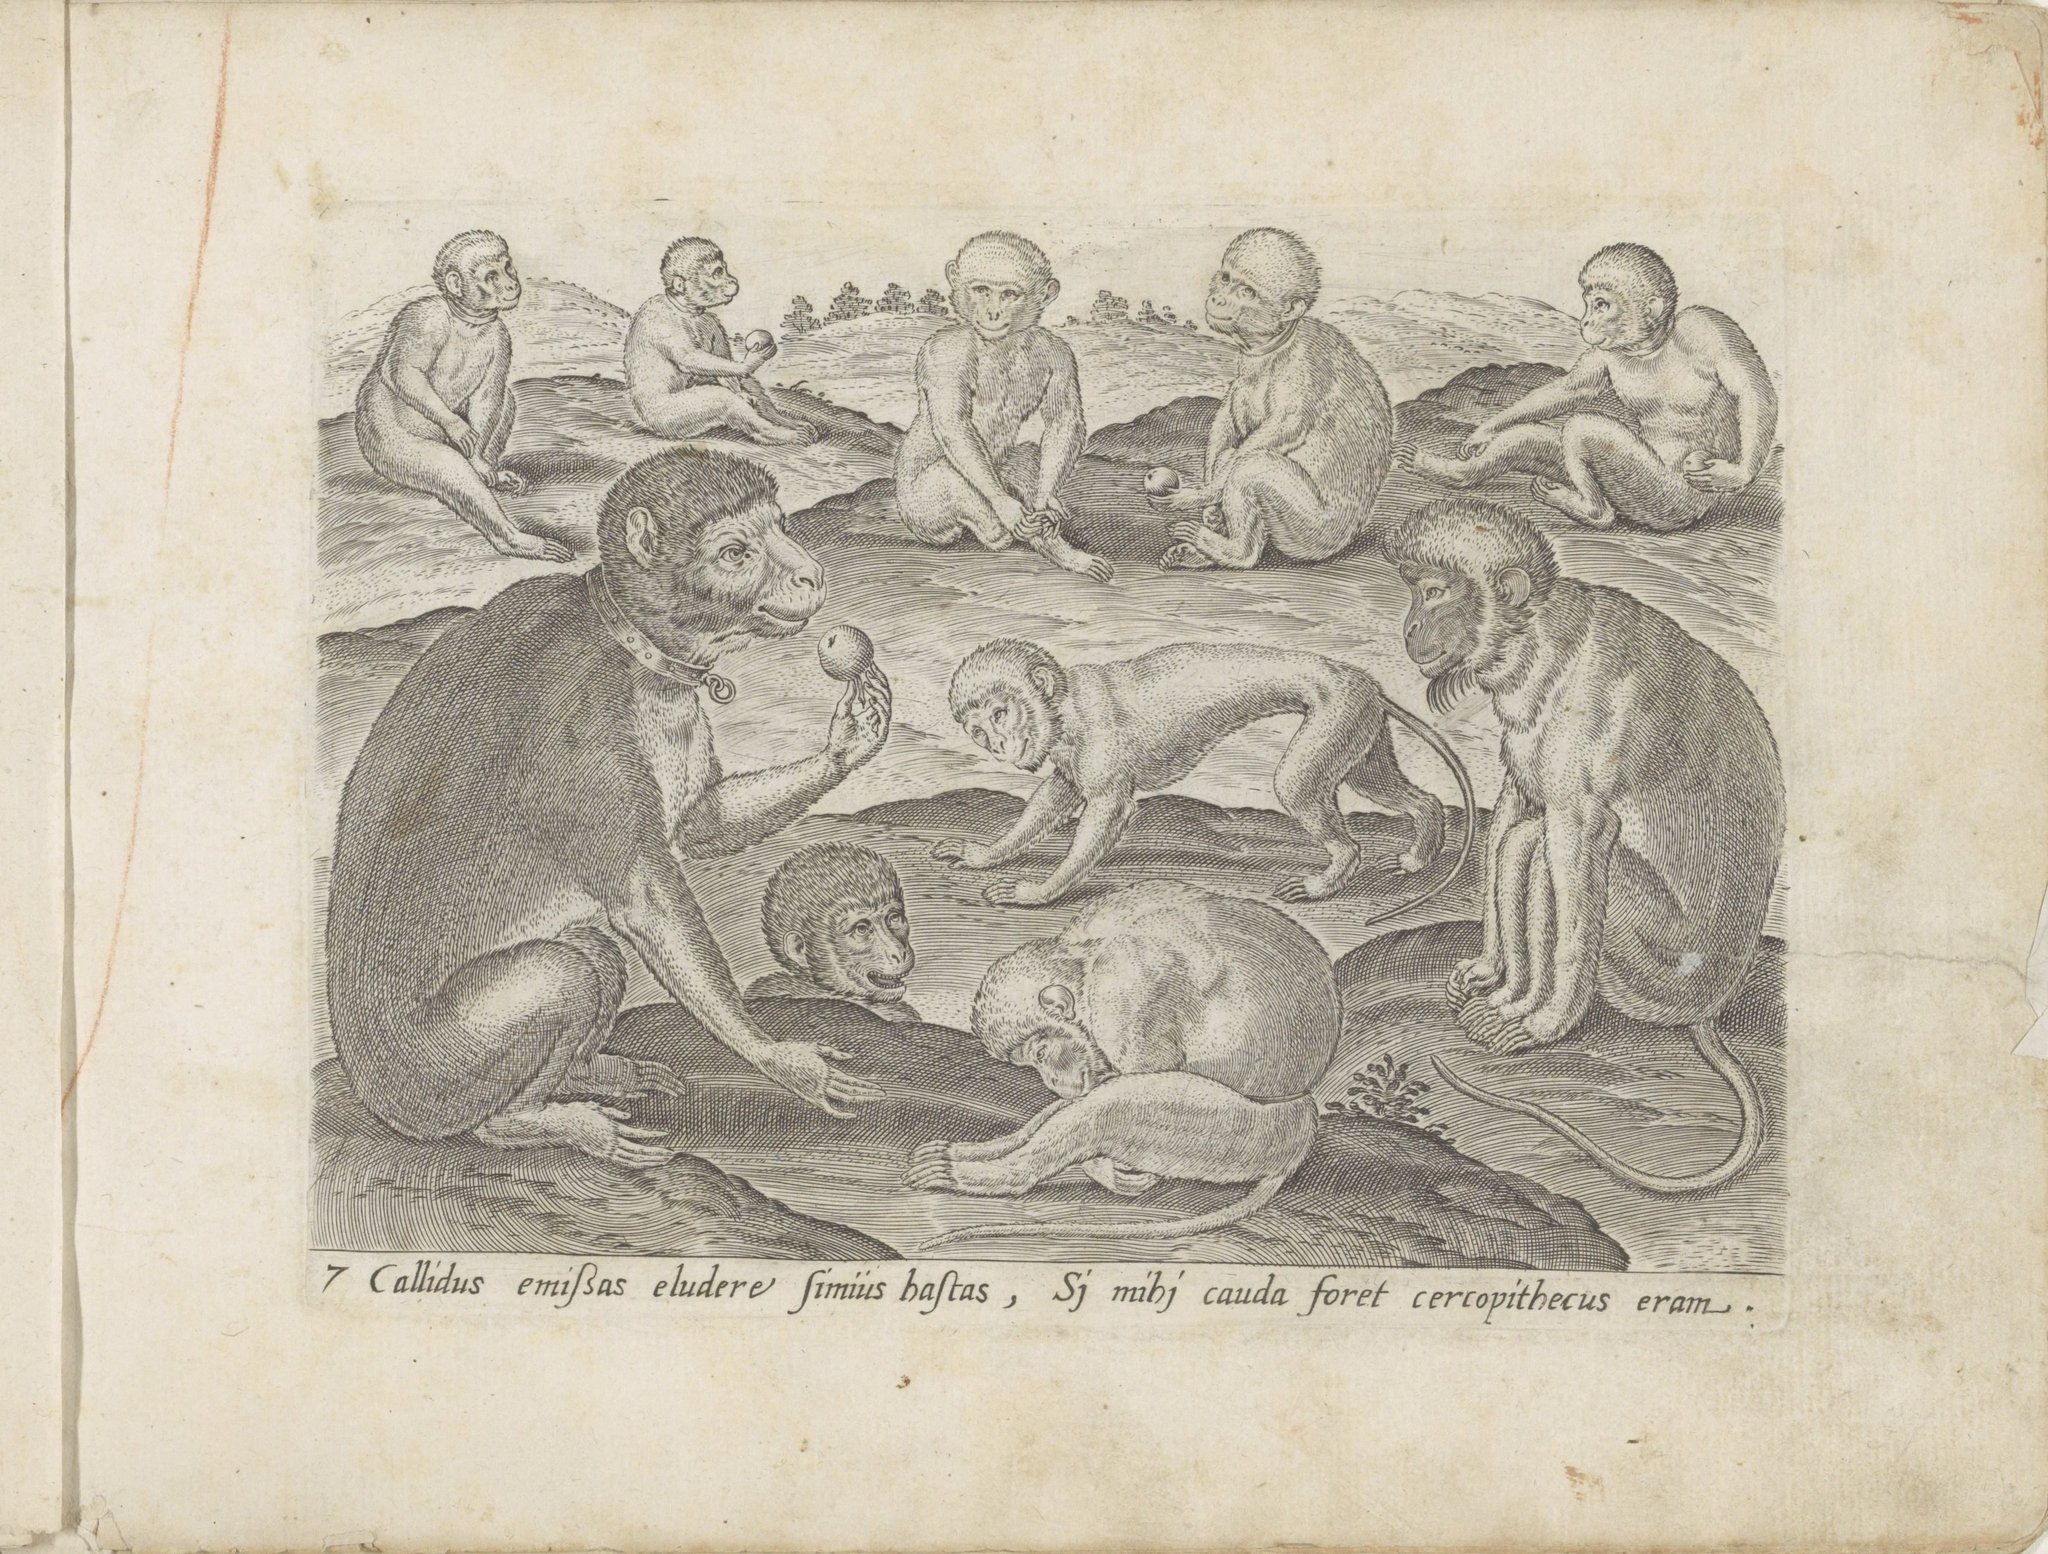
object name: album leaf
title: Verschillende apen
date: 1581-1600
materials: paper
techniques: engraving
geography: netherlands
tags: monkeys, apes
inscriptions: inscription: ‘7: Callidus emissas eludere simius hastas, Si mihi cauda foret cercopithecus eram.’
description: Apen. Op de voorgrond een grote zittende aap, naar rechts, een appel etend. Voor hem een zich krabbende aap en, rechts een aap met een sik. Op de achtergrond vijf zittende apen. Onderaan in de marge een verklarende tekst in het Latijn. Prent maakt deel uit van een album.